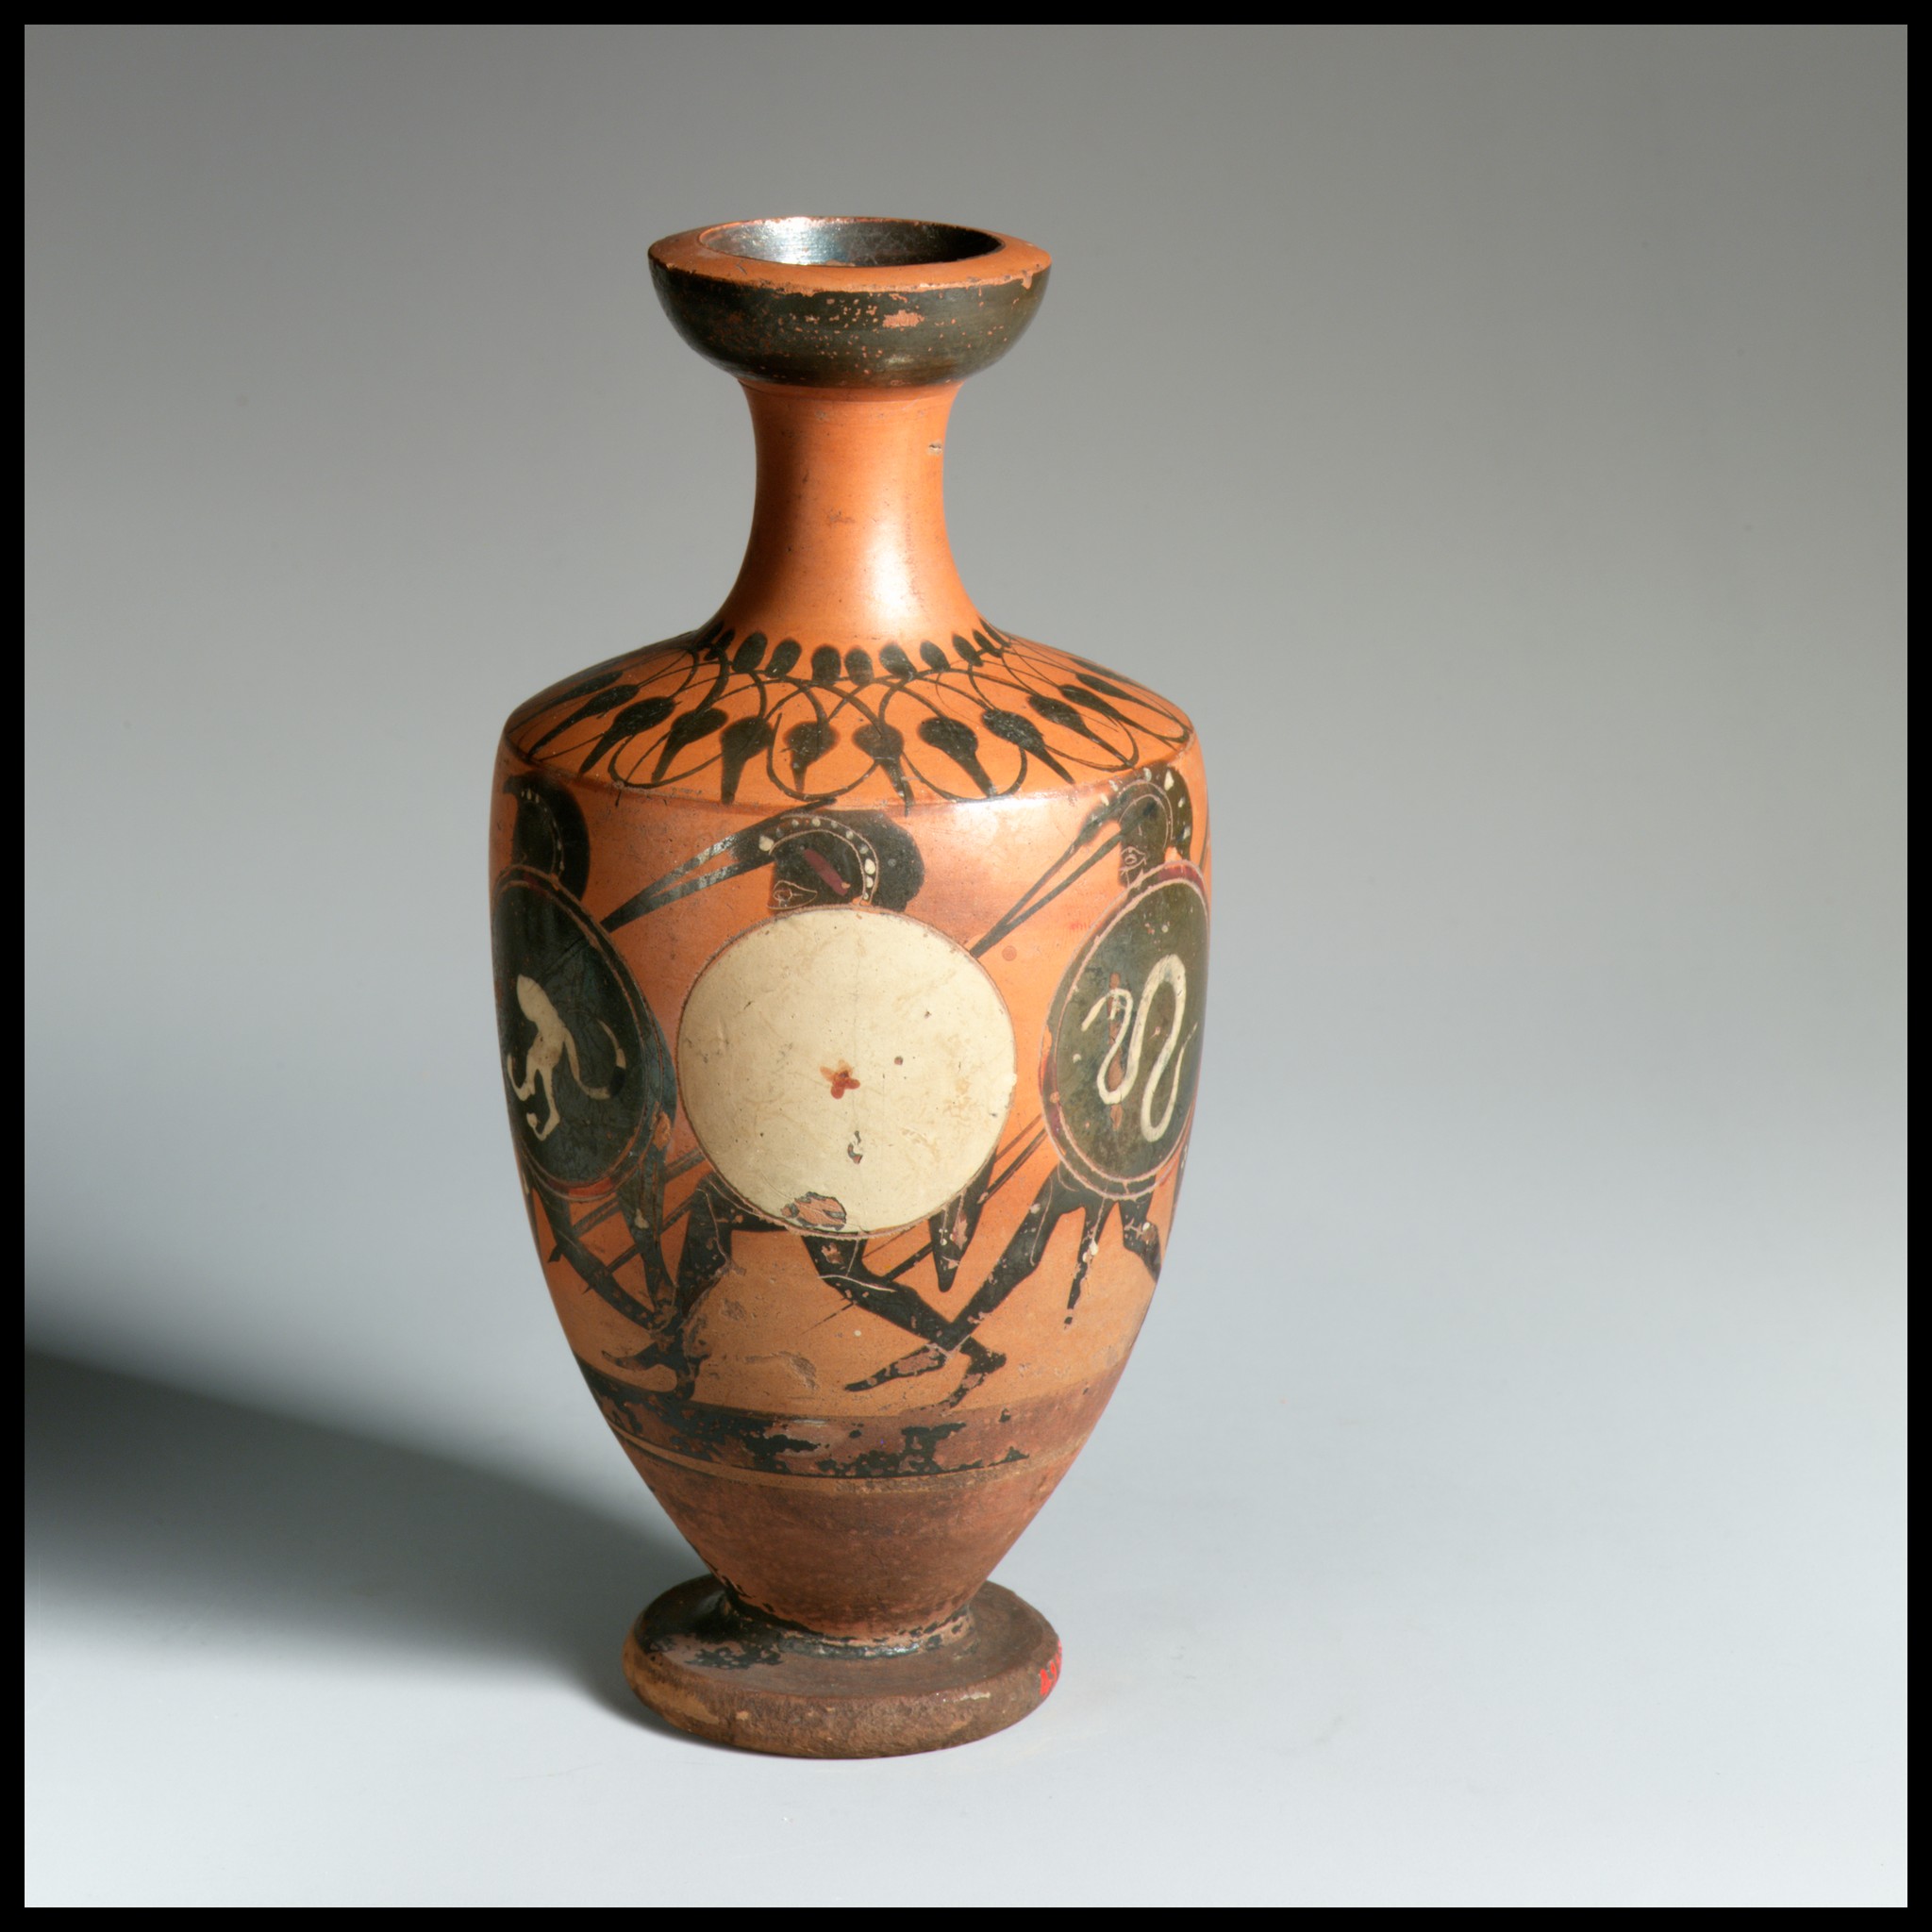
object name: lekythos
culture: greek, attic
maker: class of athens 581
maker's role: artist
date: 500-468 BCE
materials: terracotta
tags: soldiers,shields,men